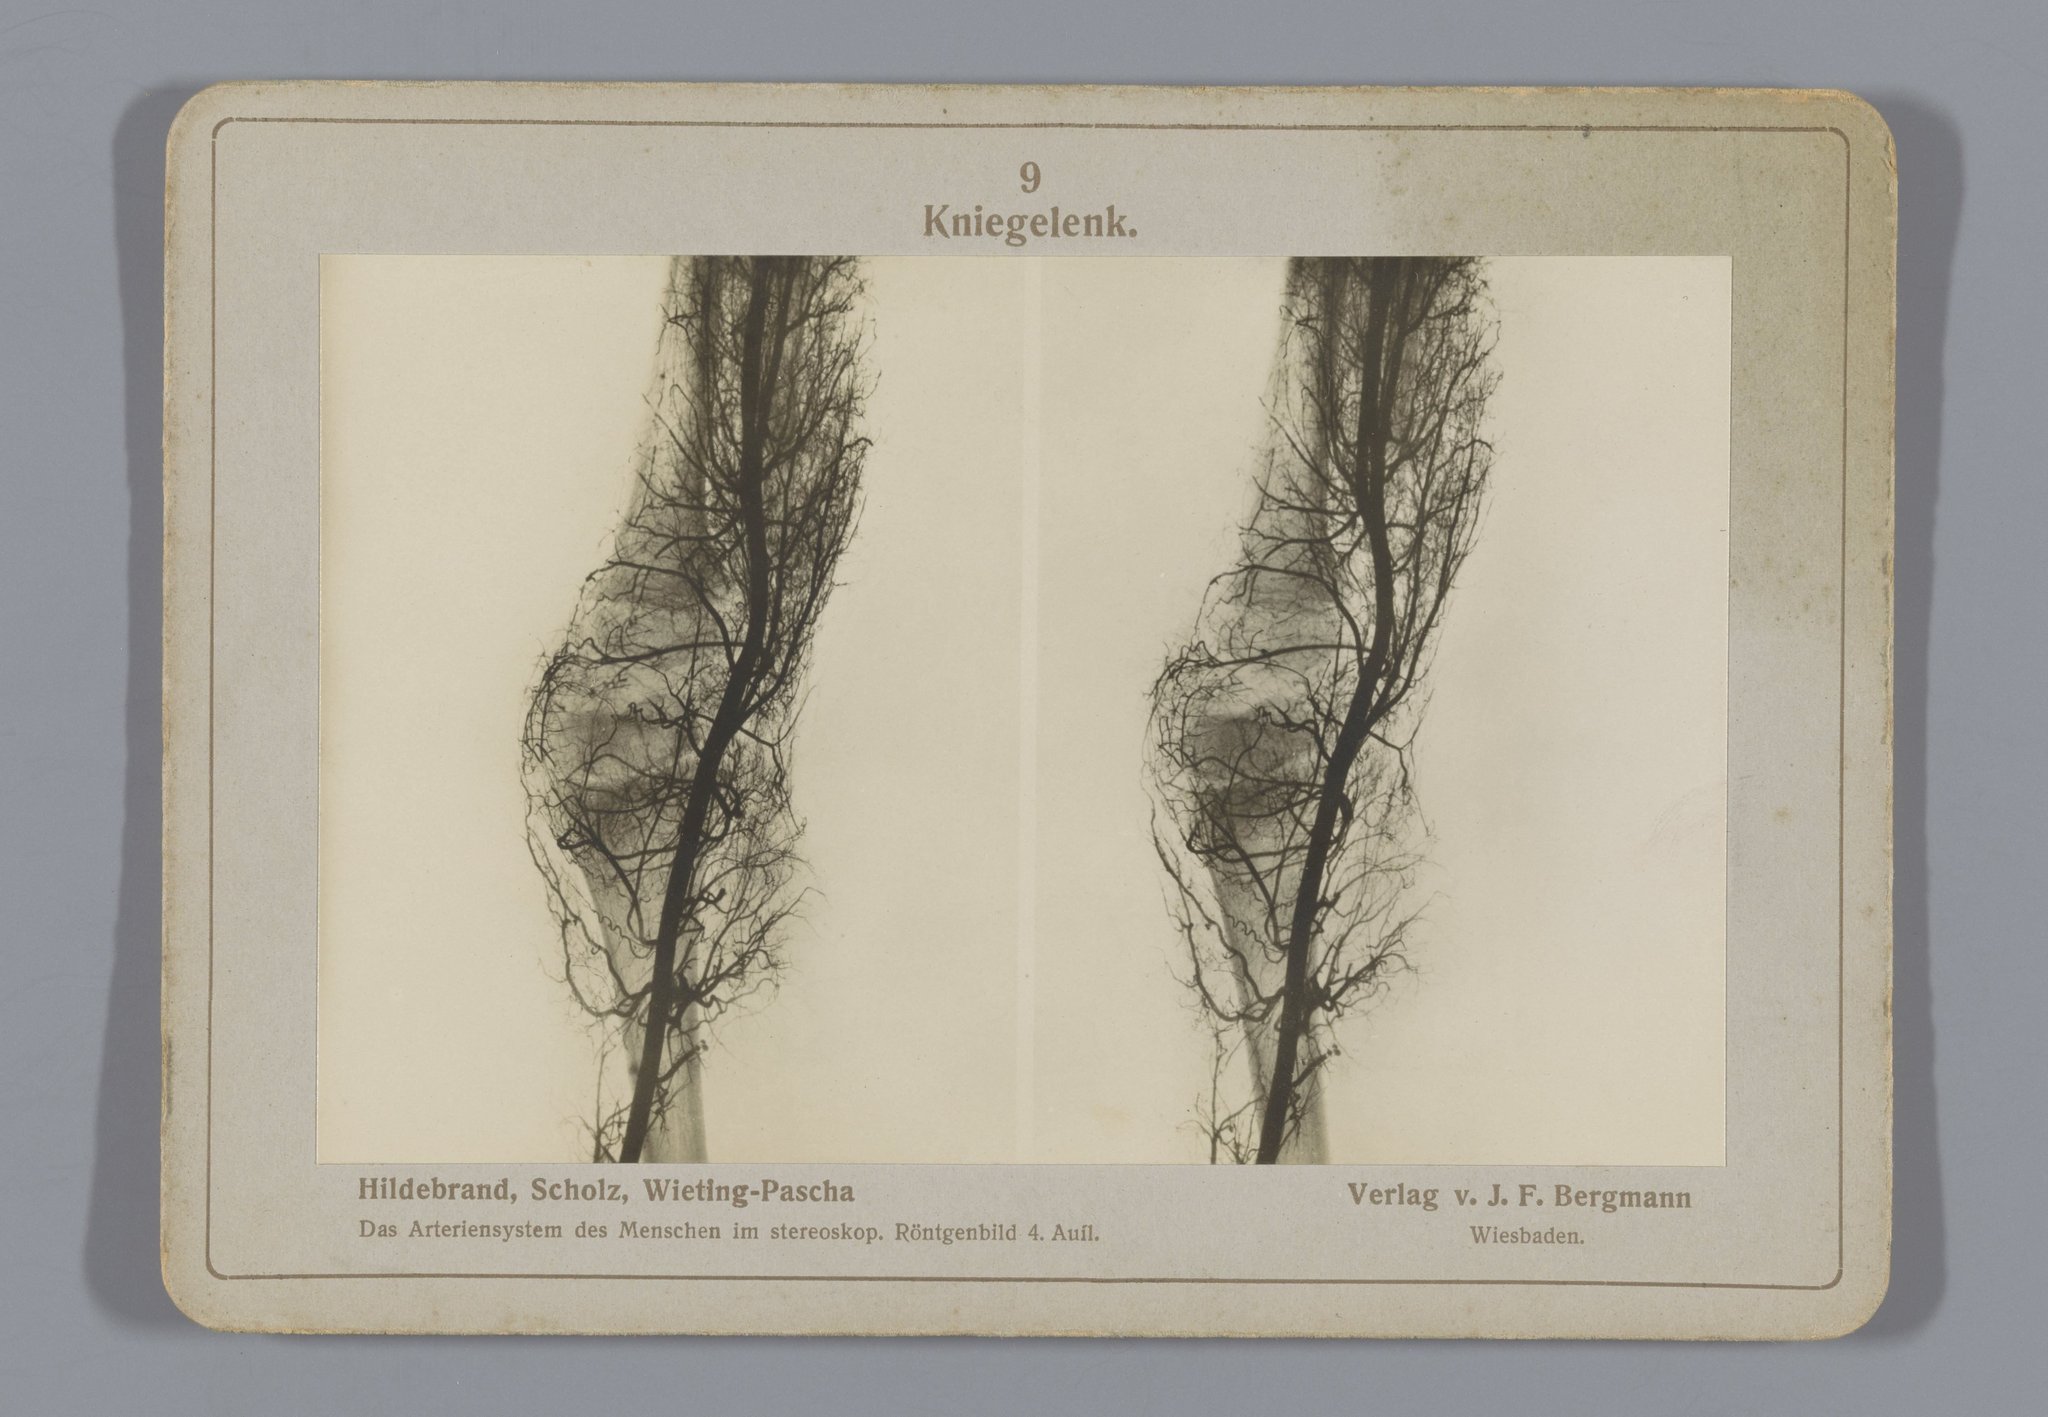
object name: x ray photograph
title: Das Arteriensystem des Menschen im stereoskop. Röntgenbild 4. Auflage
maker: joseph friedrich bergmann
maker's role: publisher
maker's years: 1849-1917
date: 1917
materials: paper, cardboard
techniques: gelatin silver print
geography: wiesbaden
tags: arteries, physiology and anatomy ~ circulatory system, knee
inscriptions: number: ‘9’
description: Foto afkomstig uit: Hildebrand, O., W. Scholz en J. Wieting. Das Arteriensystem des Menschen im stereoskopischen Röntgenbild, Sammlung von stereoskopischen Röntgenbildern aus dem Neuen Allgemeinen Krankenhaus Hamburg-Eppendorf. 4de druk. Wiesbaden: J.F. Bergmann, 1917.